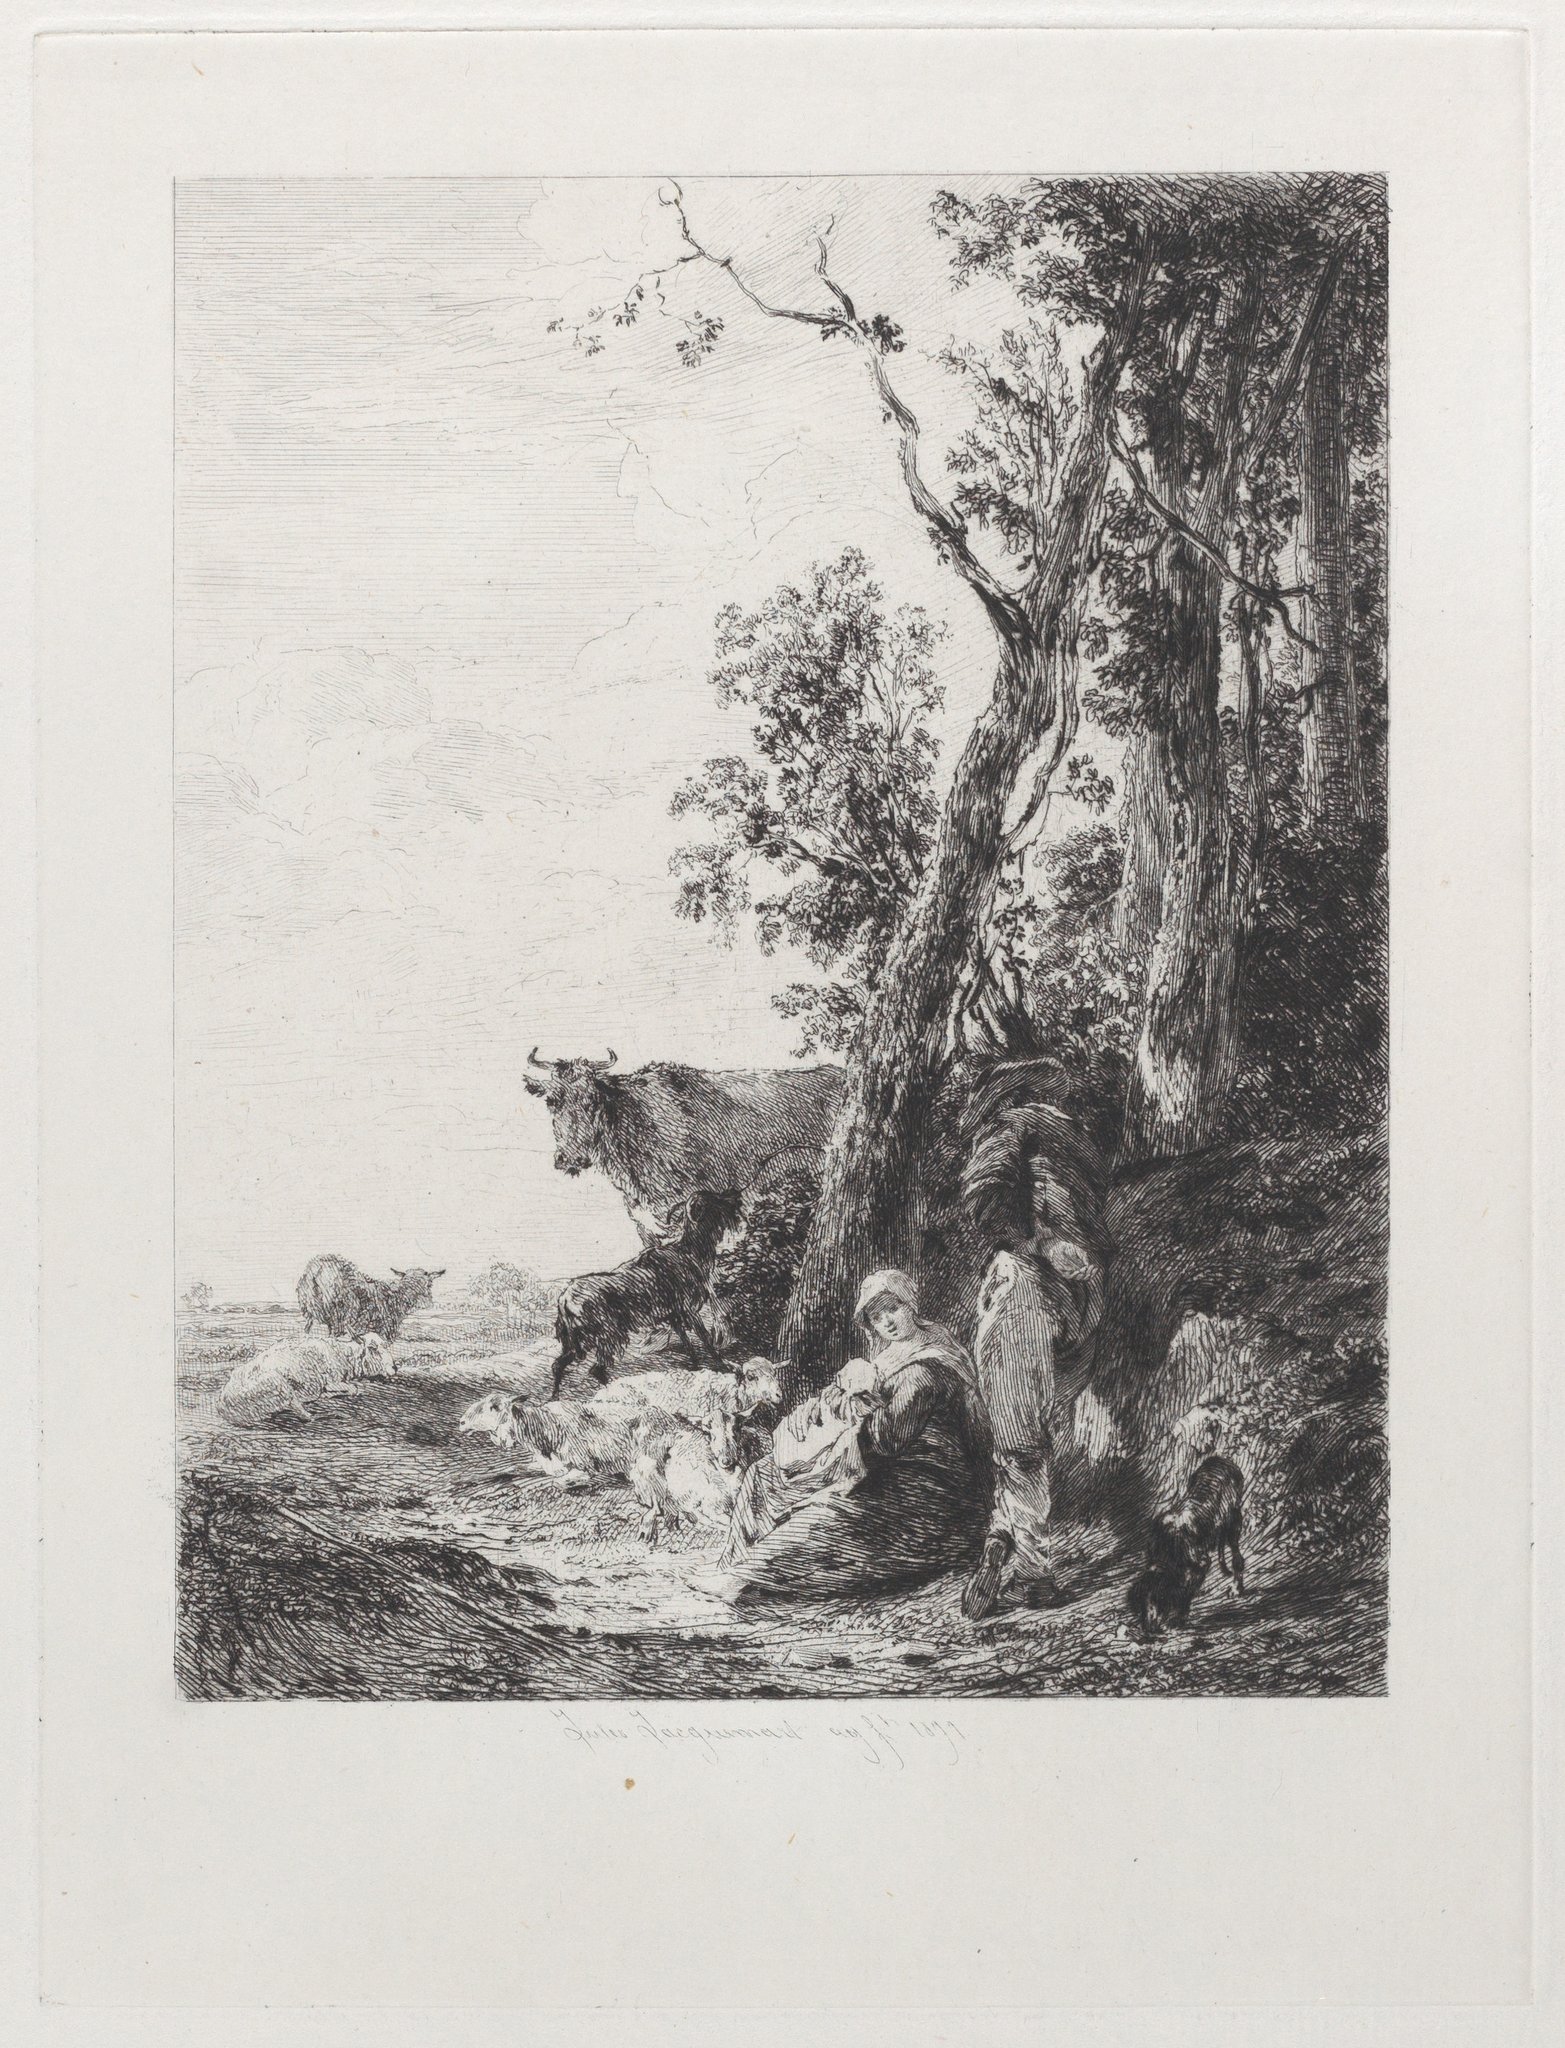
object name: print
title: Rest, a Landscape with Figures and Cattle, after Nicolaes Berchem, from "Etchings of Pictures in the Metropolitan Museum New York"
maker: jules-ferdinand jacquemart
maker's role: artist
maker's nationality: french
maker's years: 1837-1880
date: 1871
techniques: etching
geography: london